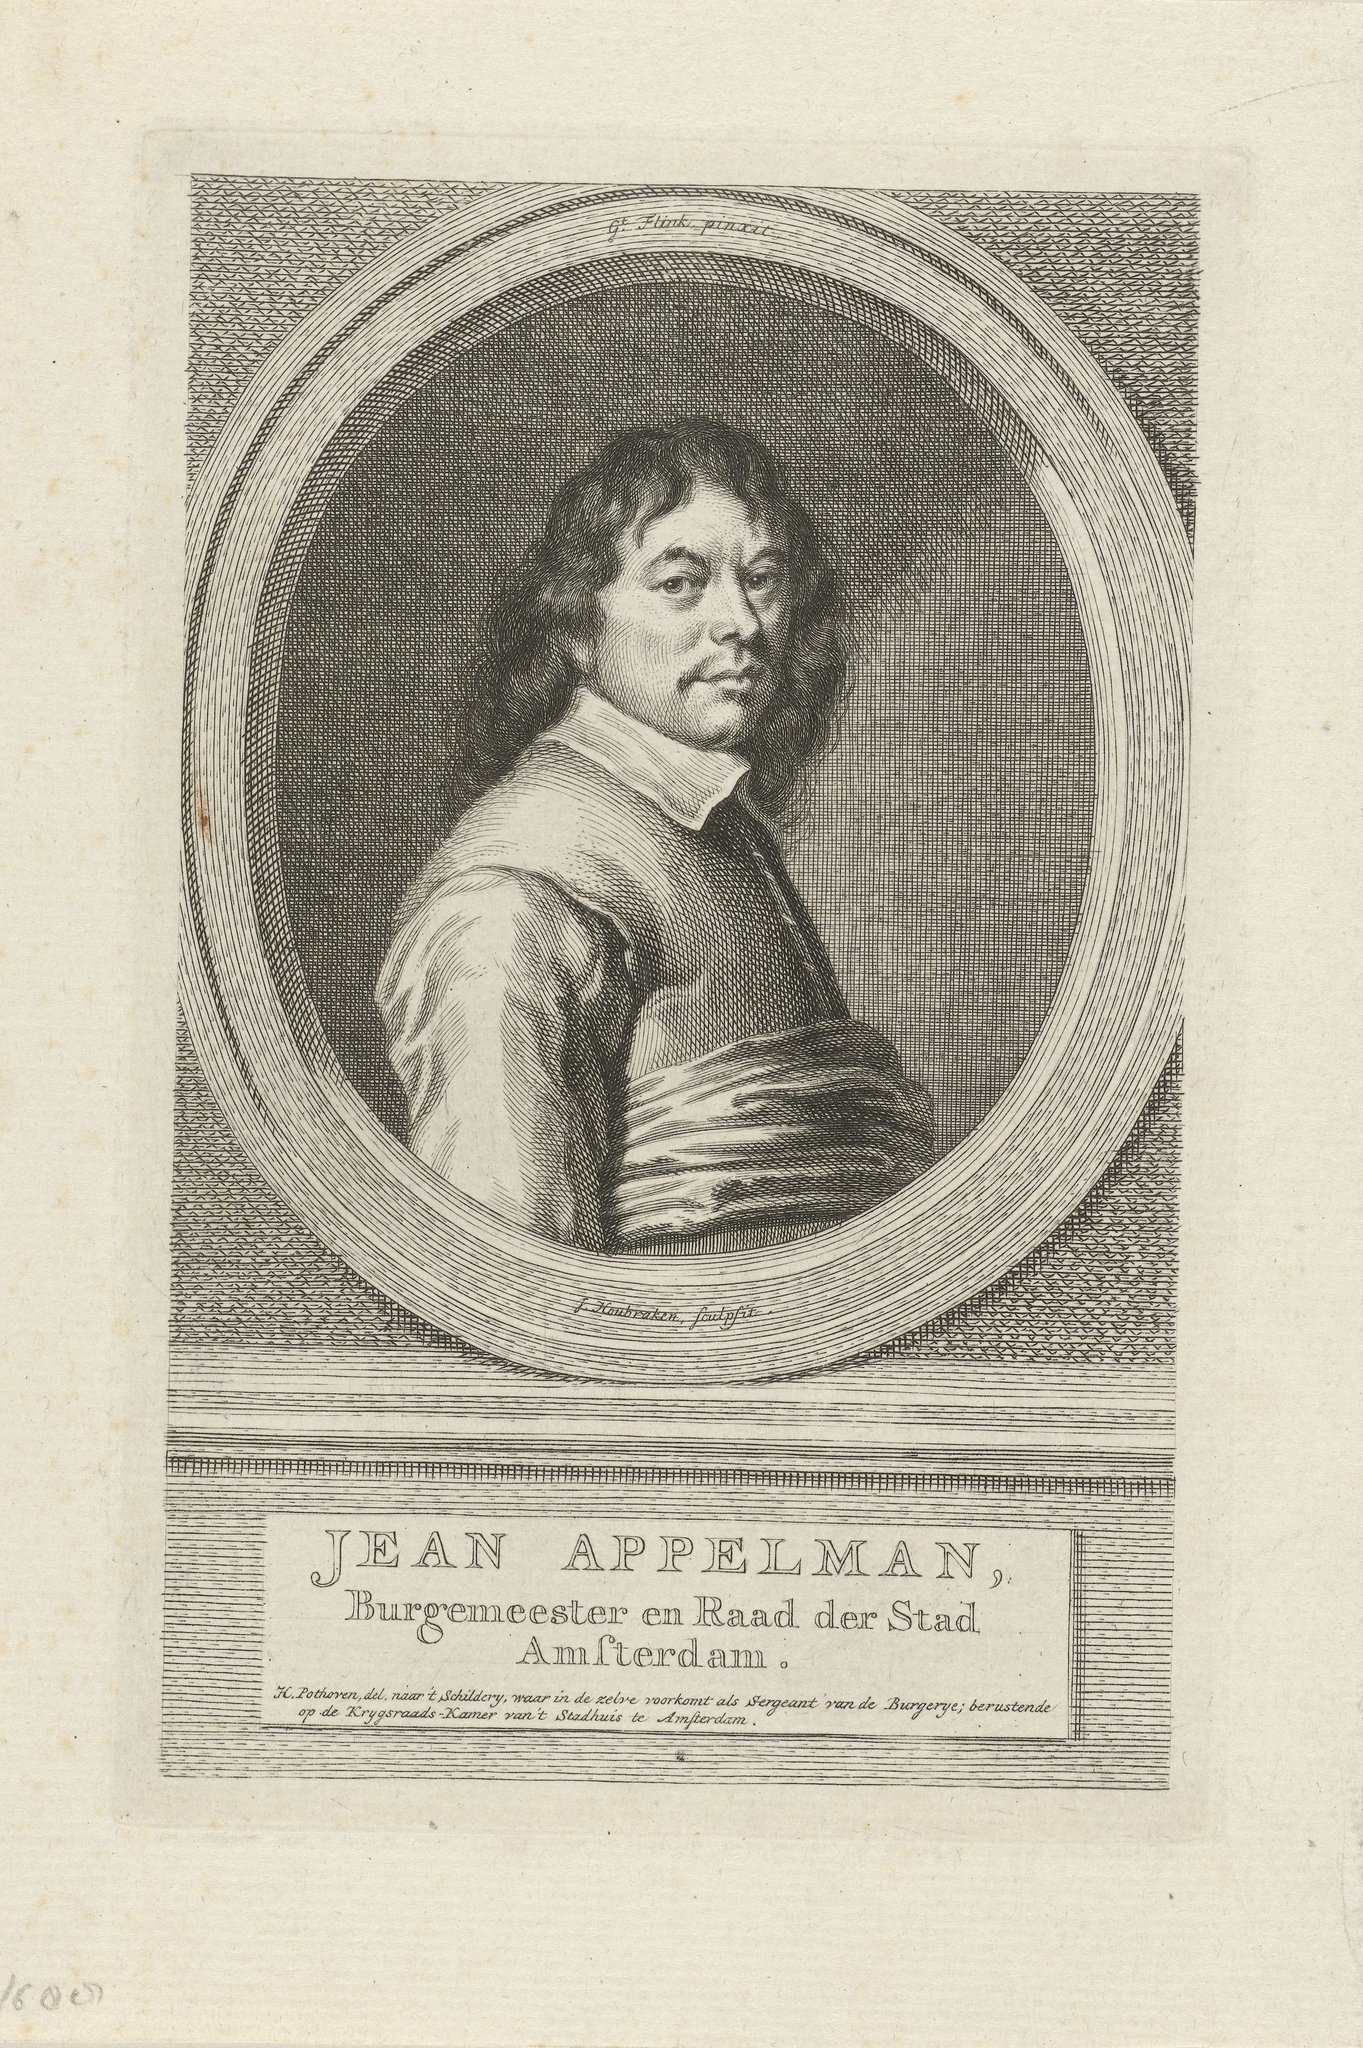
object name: print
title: Portret van Jean Appelman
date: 1749-1780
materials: paper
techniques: engraving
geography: amsterdam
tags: historical persons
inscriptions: collector's mark: Lugt 2228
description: Deze prent is oorspronkelijk bedoeld als aanvulling op Jan Wagenaars ‘Vaderlandsche historie’* en was zo vanaf 1796 verkrijgbaar bij Johannes Allart te Amsterdam. Voor de advertentie waarin Allart de 60 portretten en 7 platen, allen gegraveerd door Houbraken, ter aanvulling op Wagenaars ‘Vaderlandsche historie’ aanbiedt, zie RP-P-OB-77.766. *Van dit werk zijn in de achttiende eeuw meerdere uitgaves verschenen, zoals: Wagenaar, Jan. Vaderlandsche historie, vervattende de geschiedenissen der Vereenigde Nederlanden (…). 21 delen. Amsterdam: Isaak Tirion, 1749-1759. Wagenaar, Jan. Vaderlandsche historie, vervattende de geschiedenissen der nu Vereenigde Nederlanden (…). 21 delen. Amsterdam: weduwe Isaak Tirion, 1770. Wagenaar, Jan. Vaderlandsche historie, vervattende de geschiedenissen der nu Vereenigde Nederlanden (…). 21 delen. Amsterdam, Leiden, Dordrecht en Harlingen: P. Schouten e.a., 1782. Wagenaar, Jan. Vaderlandsche historie, vervattende de geschiedenissen der nu Vereenigde Nederlanden (…). 21 delen. Amsterdam: Johannes Allart, 1790-1796.